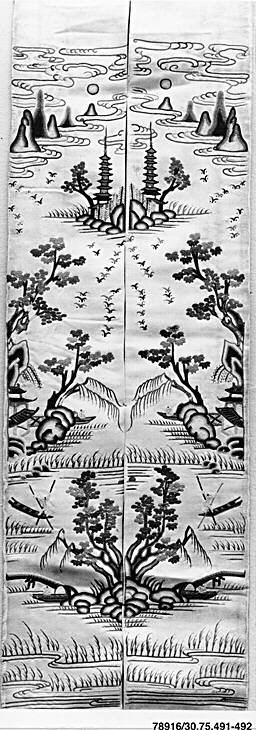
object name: sleeve band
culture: chinese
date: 1801-1900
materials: metal thread, silk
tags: trees